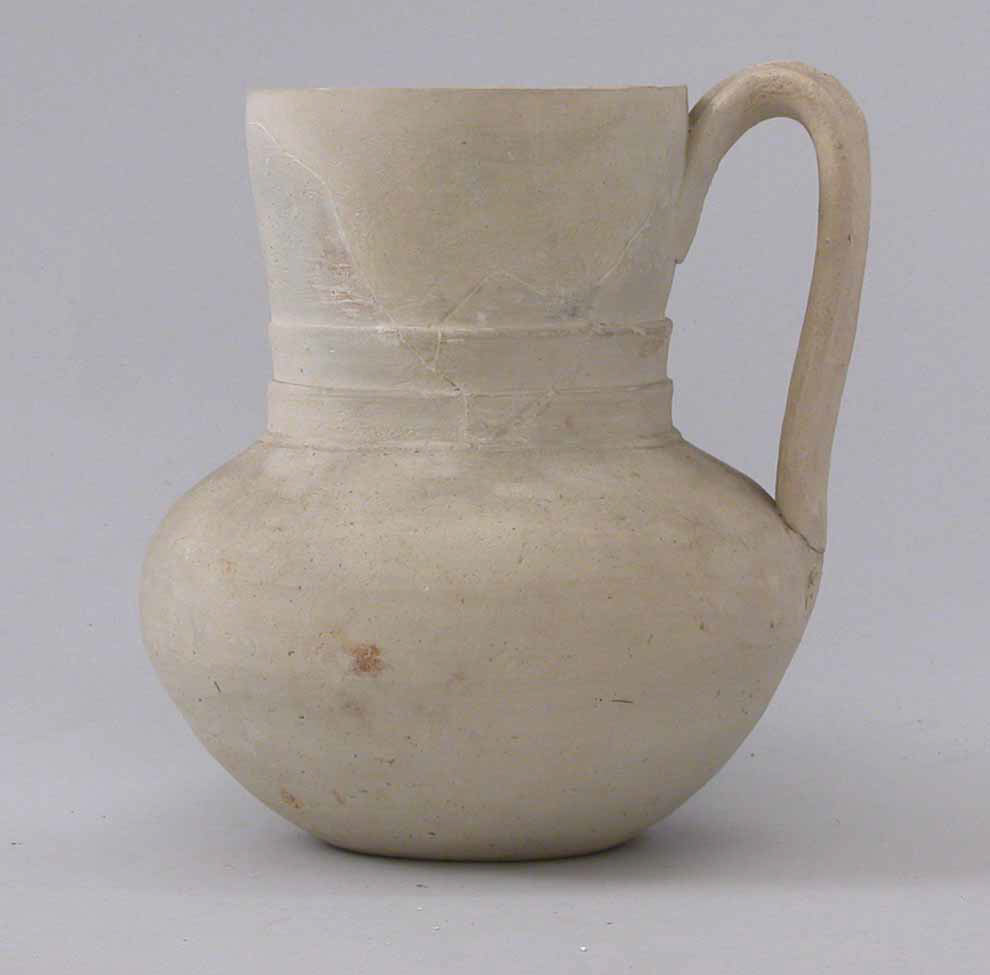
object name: ewer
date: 801-900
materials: earthenware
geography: iran